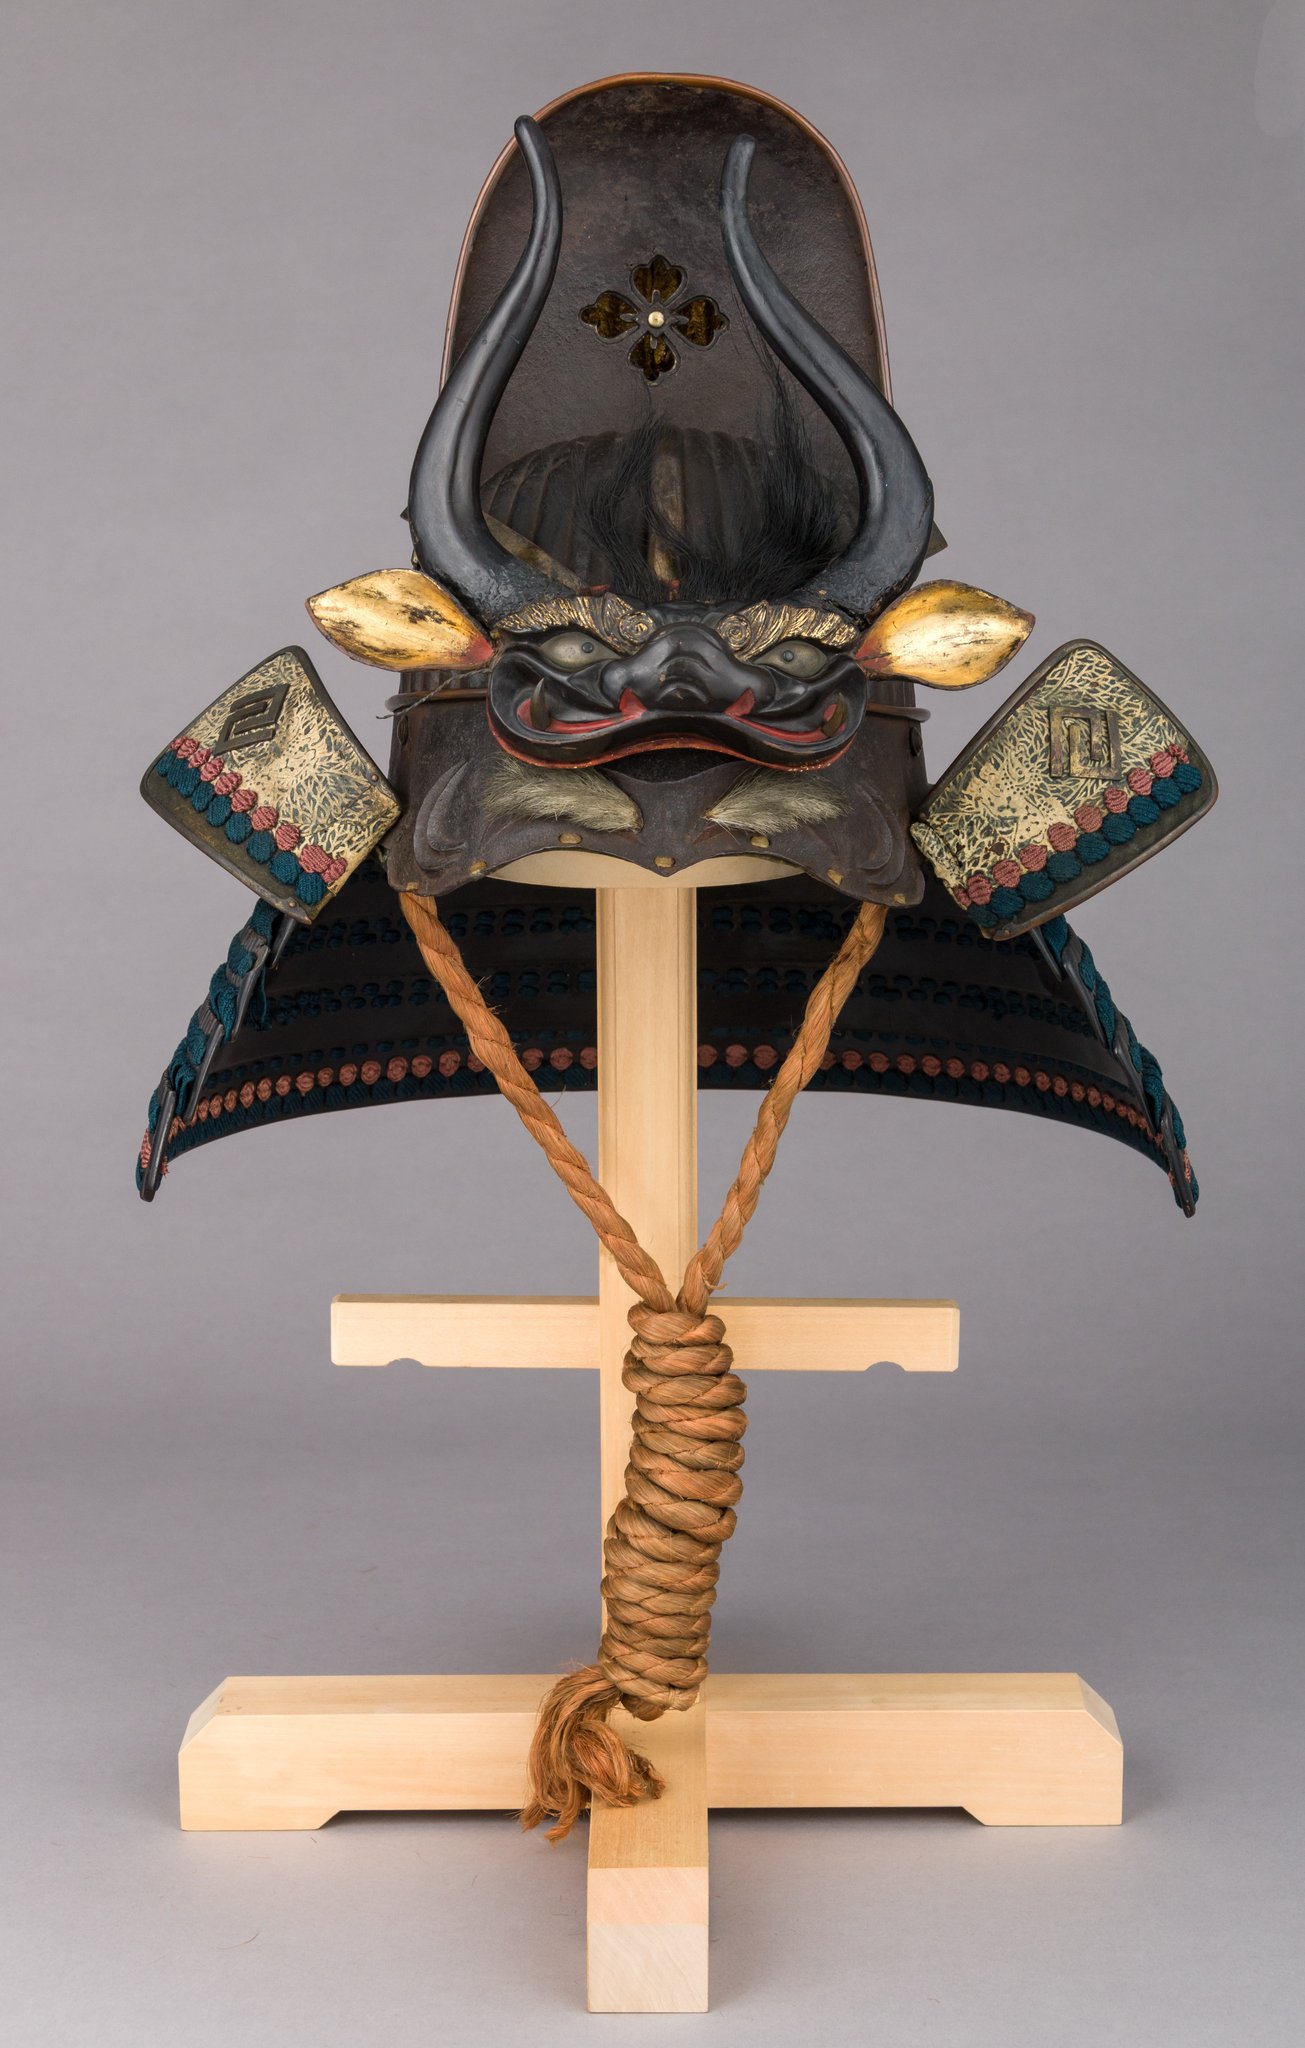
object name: helmet in the shape of a chinese courtier s hat i tōkan nari i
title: Helmet in the Shape of a Chinese Courtier’s Hat (Tōkan-Nari)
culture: japanese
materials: brass, copper, gold, hair, iron, lacquer, leather, silk, wood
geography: japan